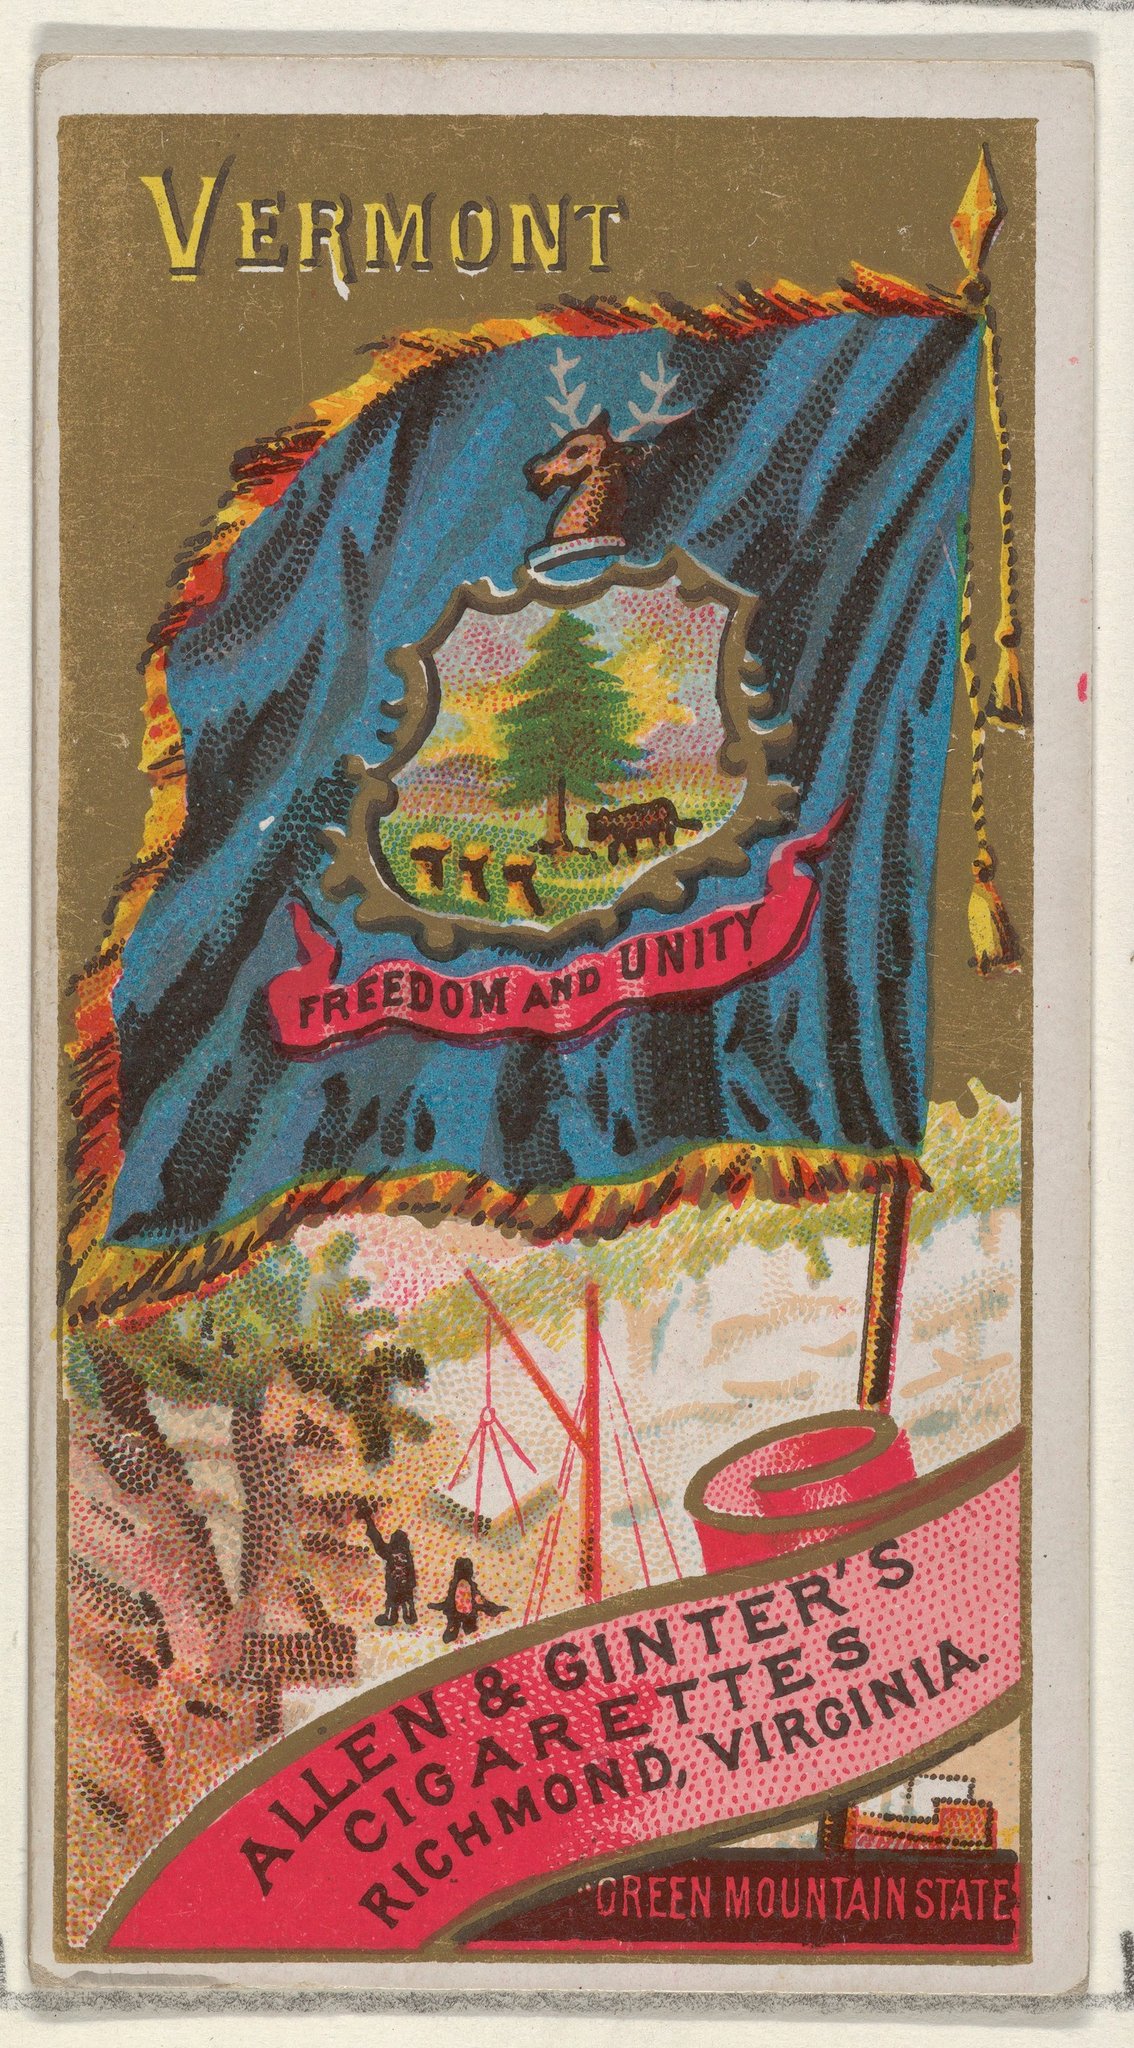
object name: print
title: Vermont, from Flags of the States and Territories (N11) for Allen & Ginter Cigarettes Brands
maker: allen & ginter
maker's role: publisher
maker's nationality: american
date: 1888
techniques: color lithograph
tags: flags